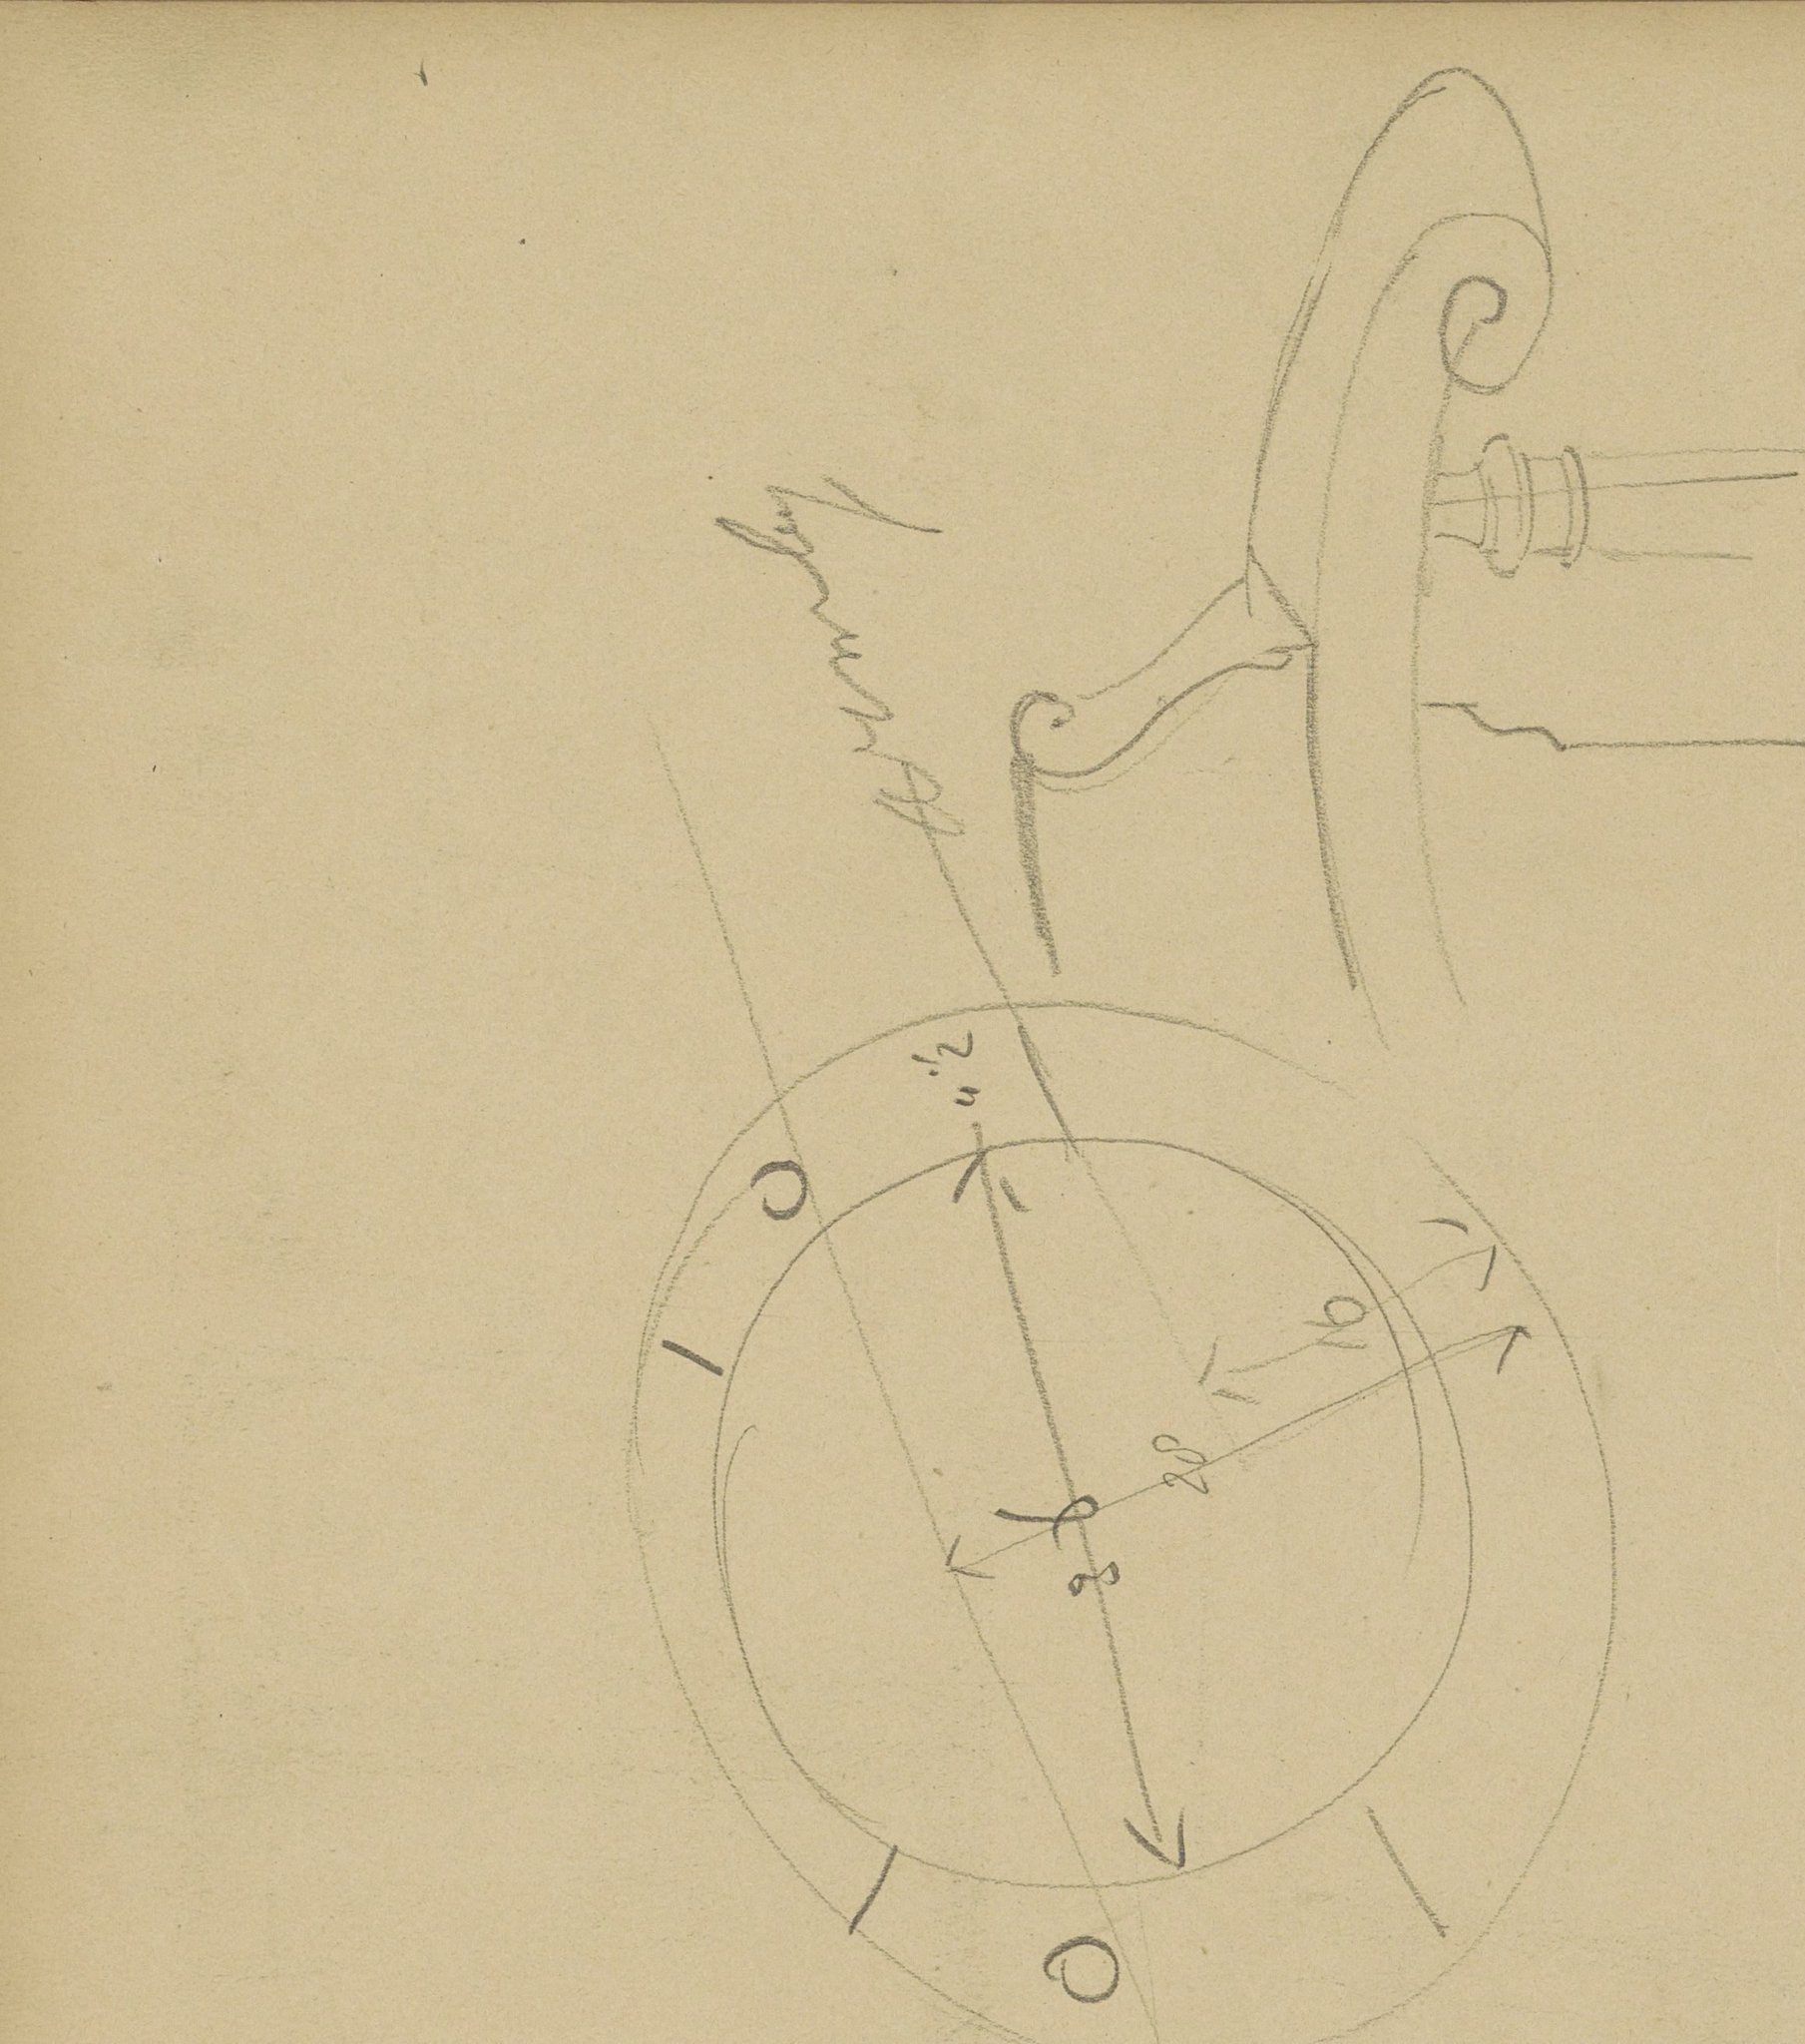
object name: sketchbook leaf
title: Patrijspoort en een leuning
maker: carel adolph lion cachet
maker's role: draughtsman, print maker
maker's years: 1864-1945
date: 1906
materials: paper, pencil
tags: parts of ship's exterior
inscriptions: annotation: ‘armb[...]’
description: Blad 12 verso uit een schetsboek met 27 bladen.